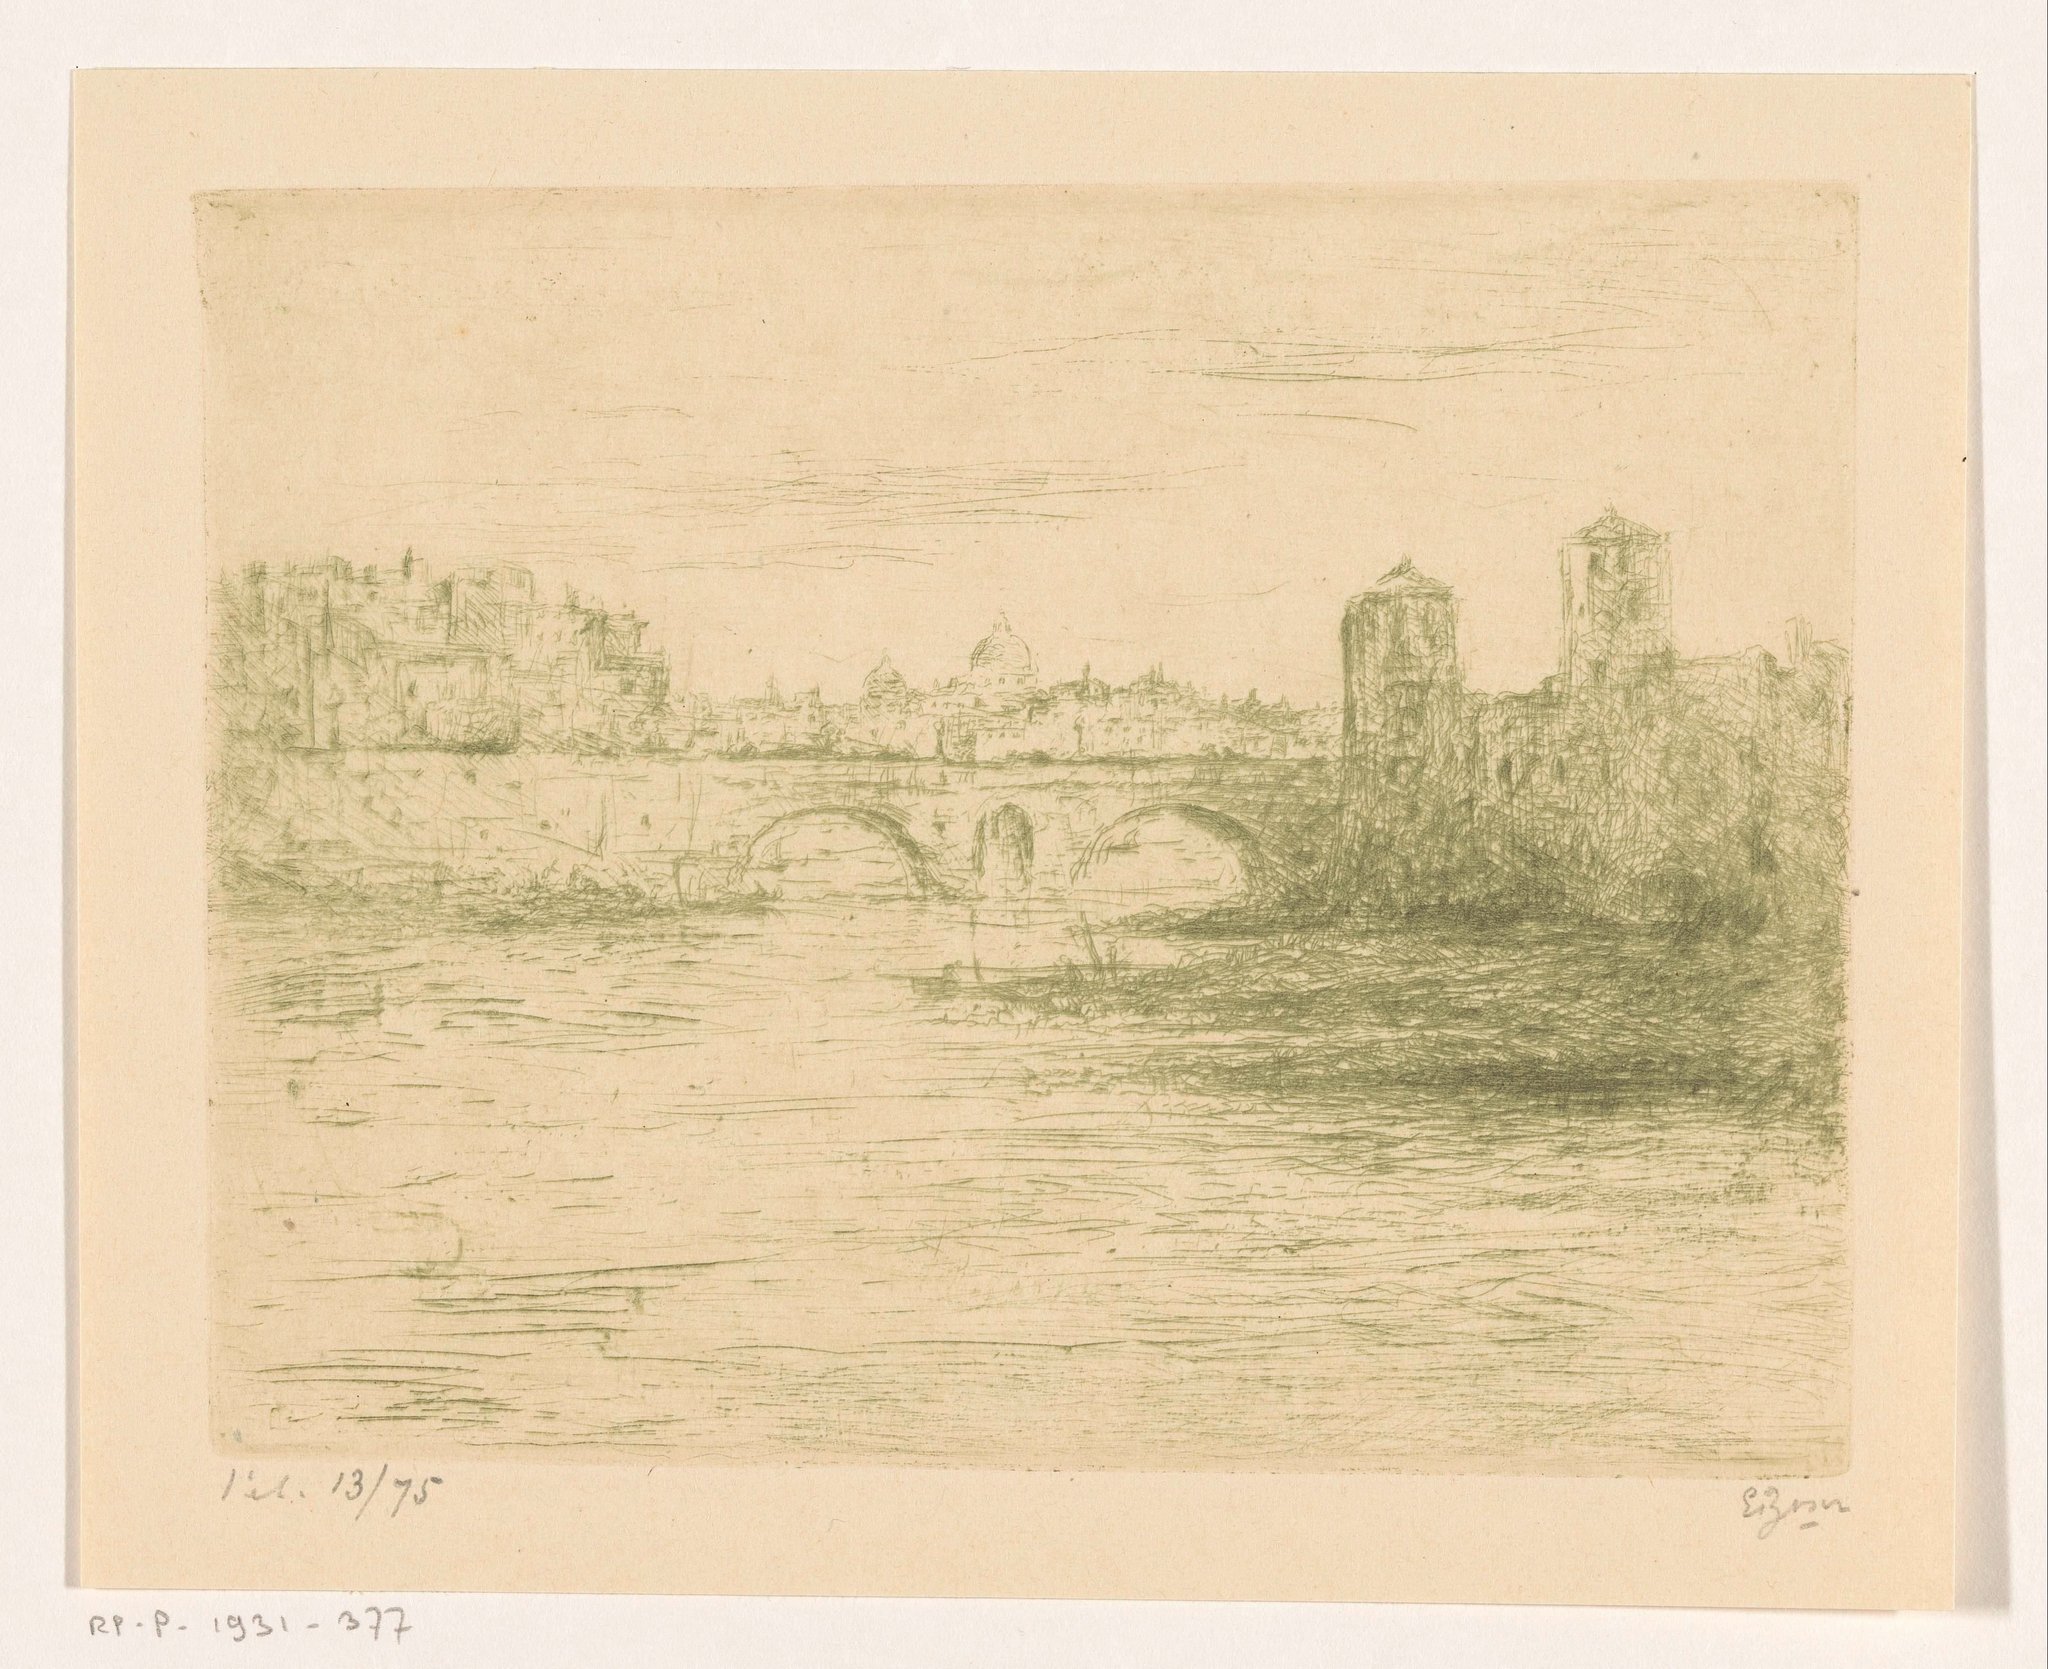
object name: print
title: Tiber, Rome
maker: etienne bosch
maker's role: print maker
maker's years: 1863-1933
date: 1873-1931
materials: paper, ink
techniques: drypoint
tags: bridge in city across river, canal, etc. - ii - ideal city, rome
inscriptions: signature: ‘EBosch’, edition: ‘1e et. 13/75’, collector's mark: Lugt 2228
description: Gezicht op Rome met op de voorgrond de rivier, in het midden een brug en op de achtergrond de toren van de Sint Pieter.